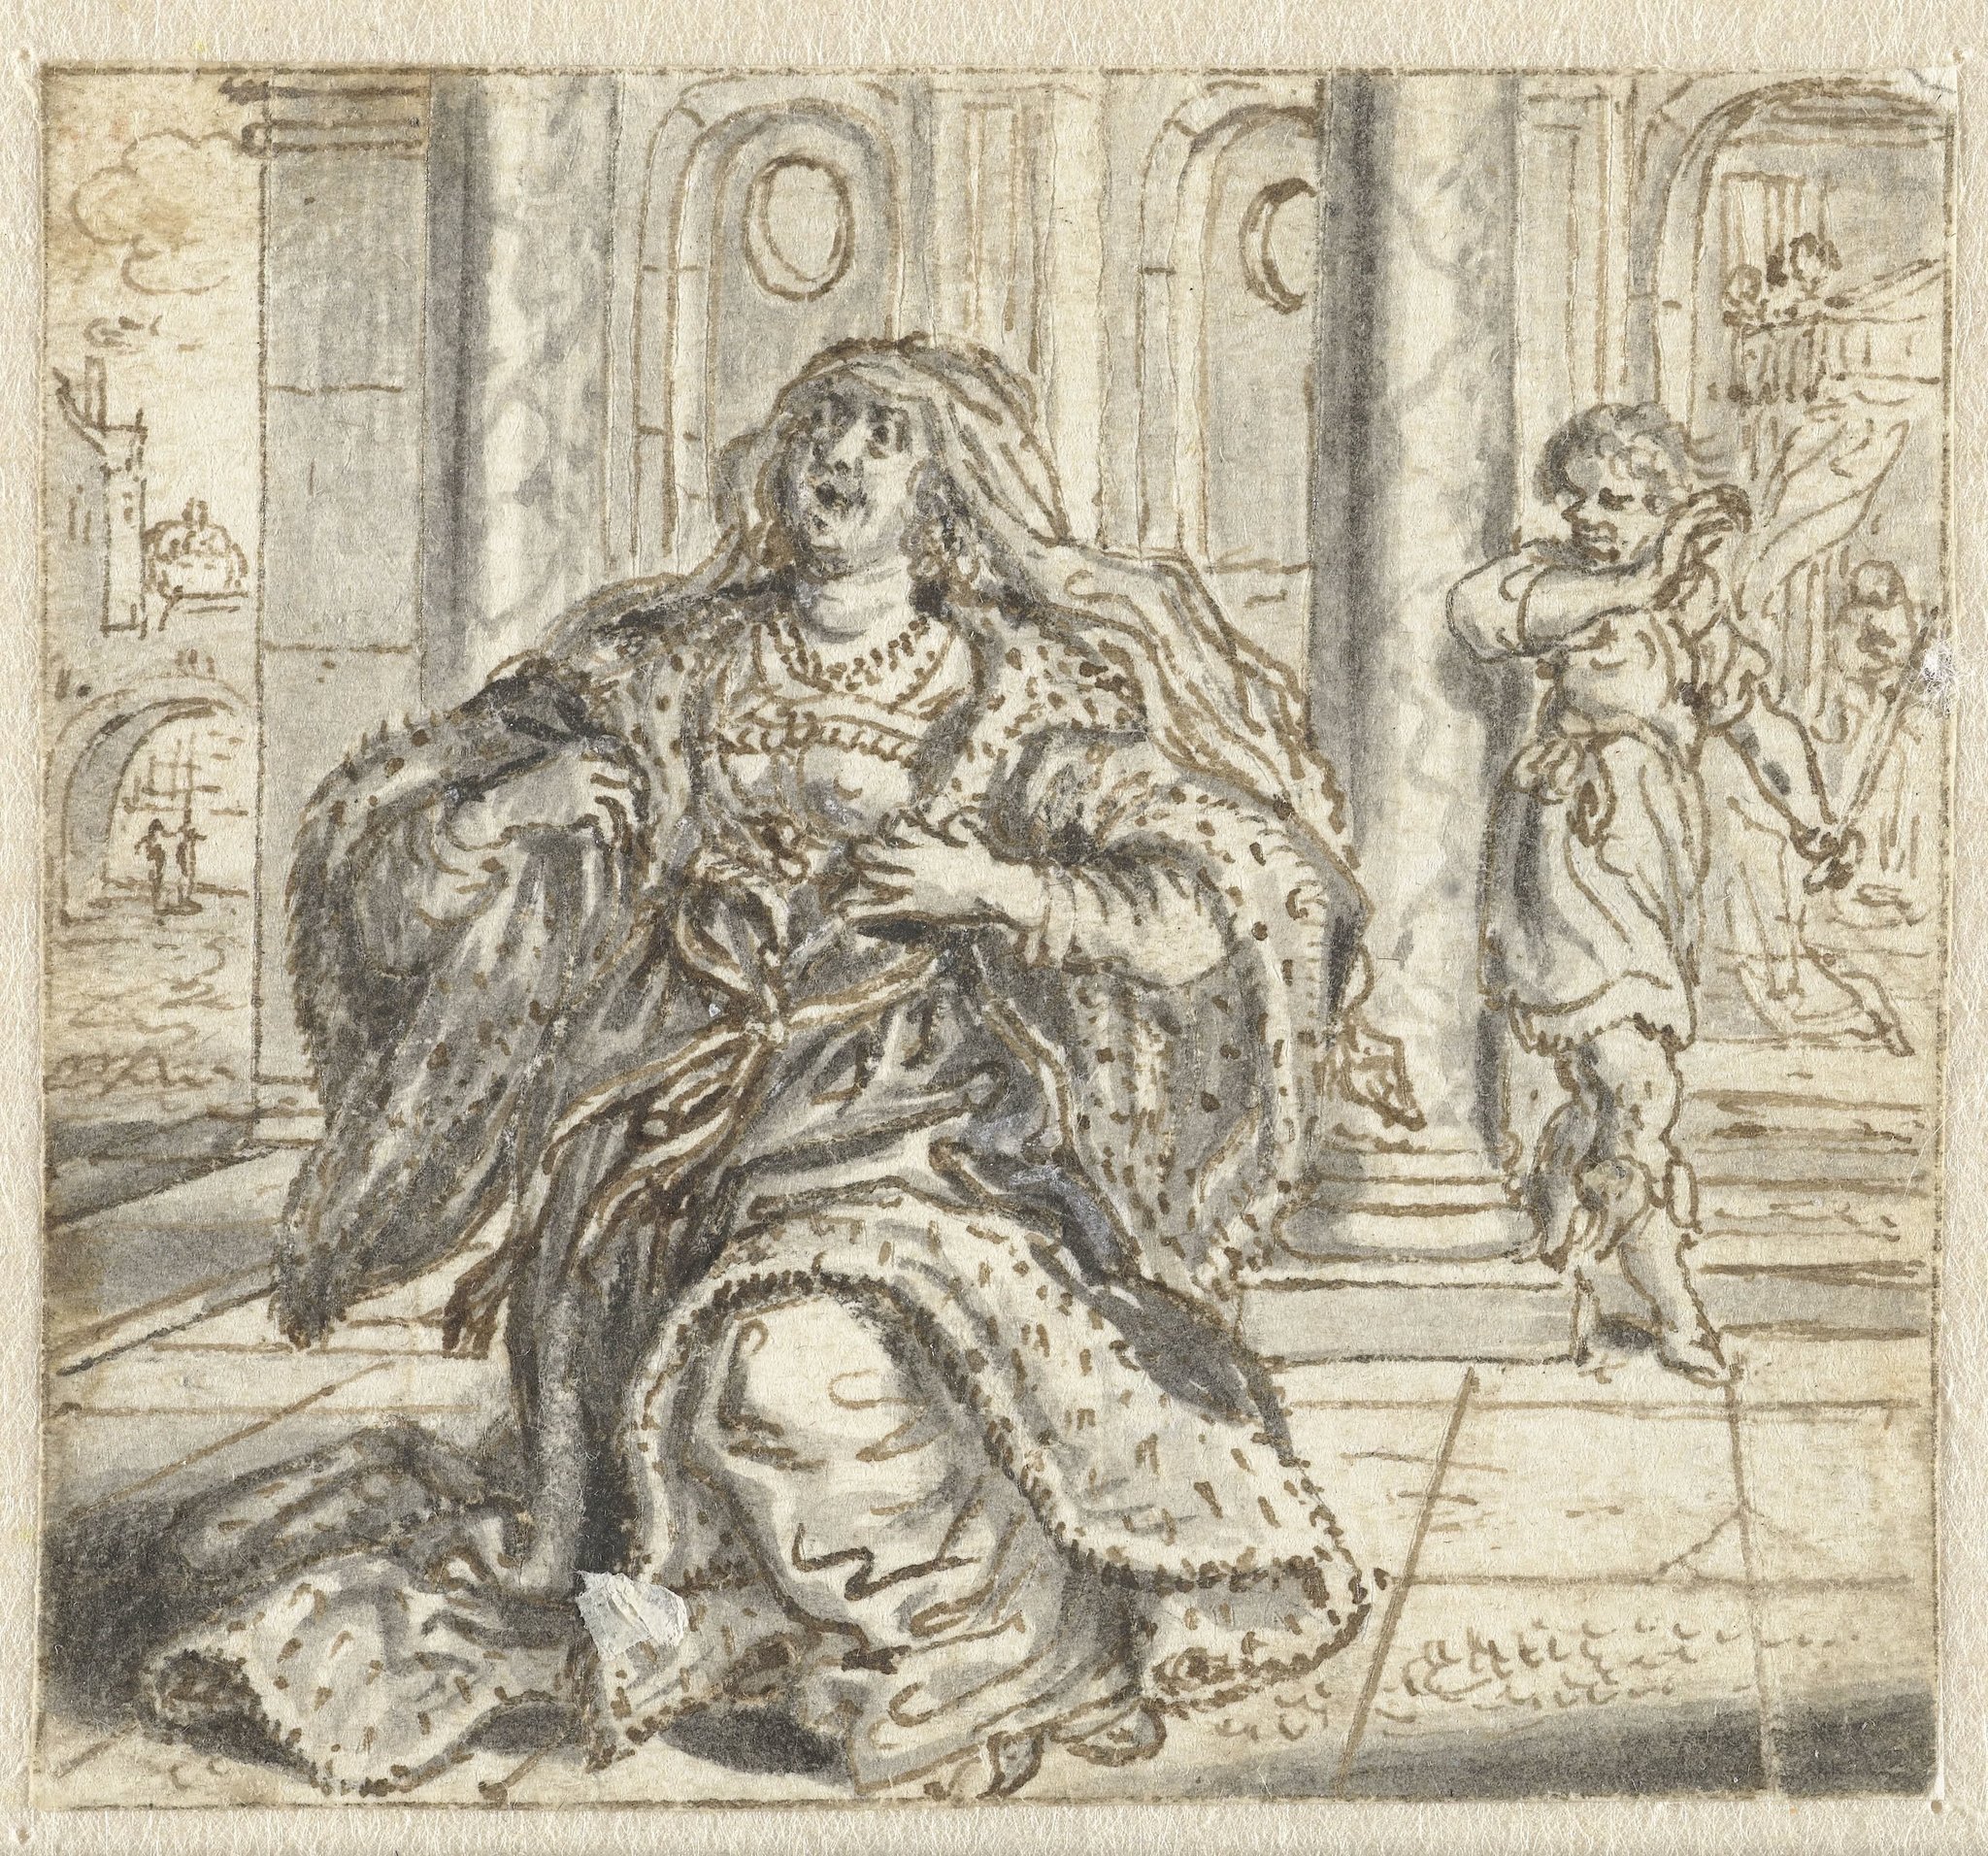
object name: drawing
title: Desolate Tamar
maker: adriaen pietersz van de venne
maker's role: draughtsman, painter, print maker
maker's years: 1589-1662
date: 1634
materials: paint, ink, paper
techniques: brush, pen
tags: story of judah and tamar (genesis 38), (scenes from) specific works of literature (with author, title)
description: Ontwerp voor een illustratie in Jacob Cats' 'Hovwelyck ...' van 1634: de berouwvolle Tamar.